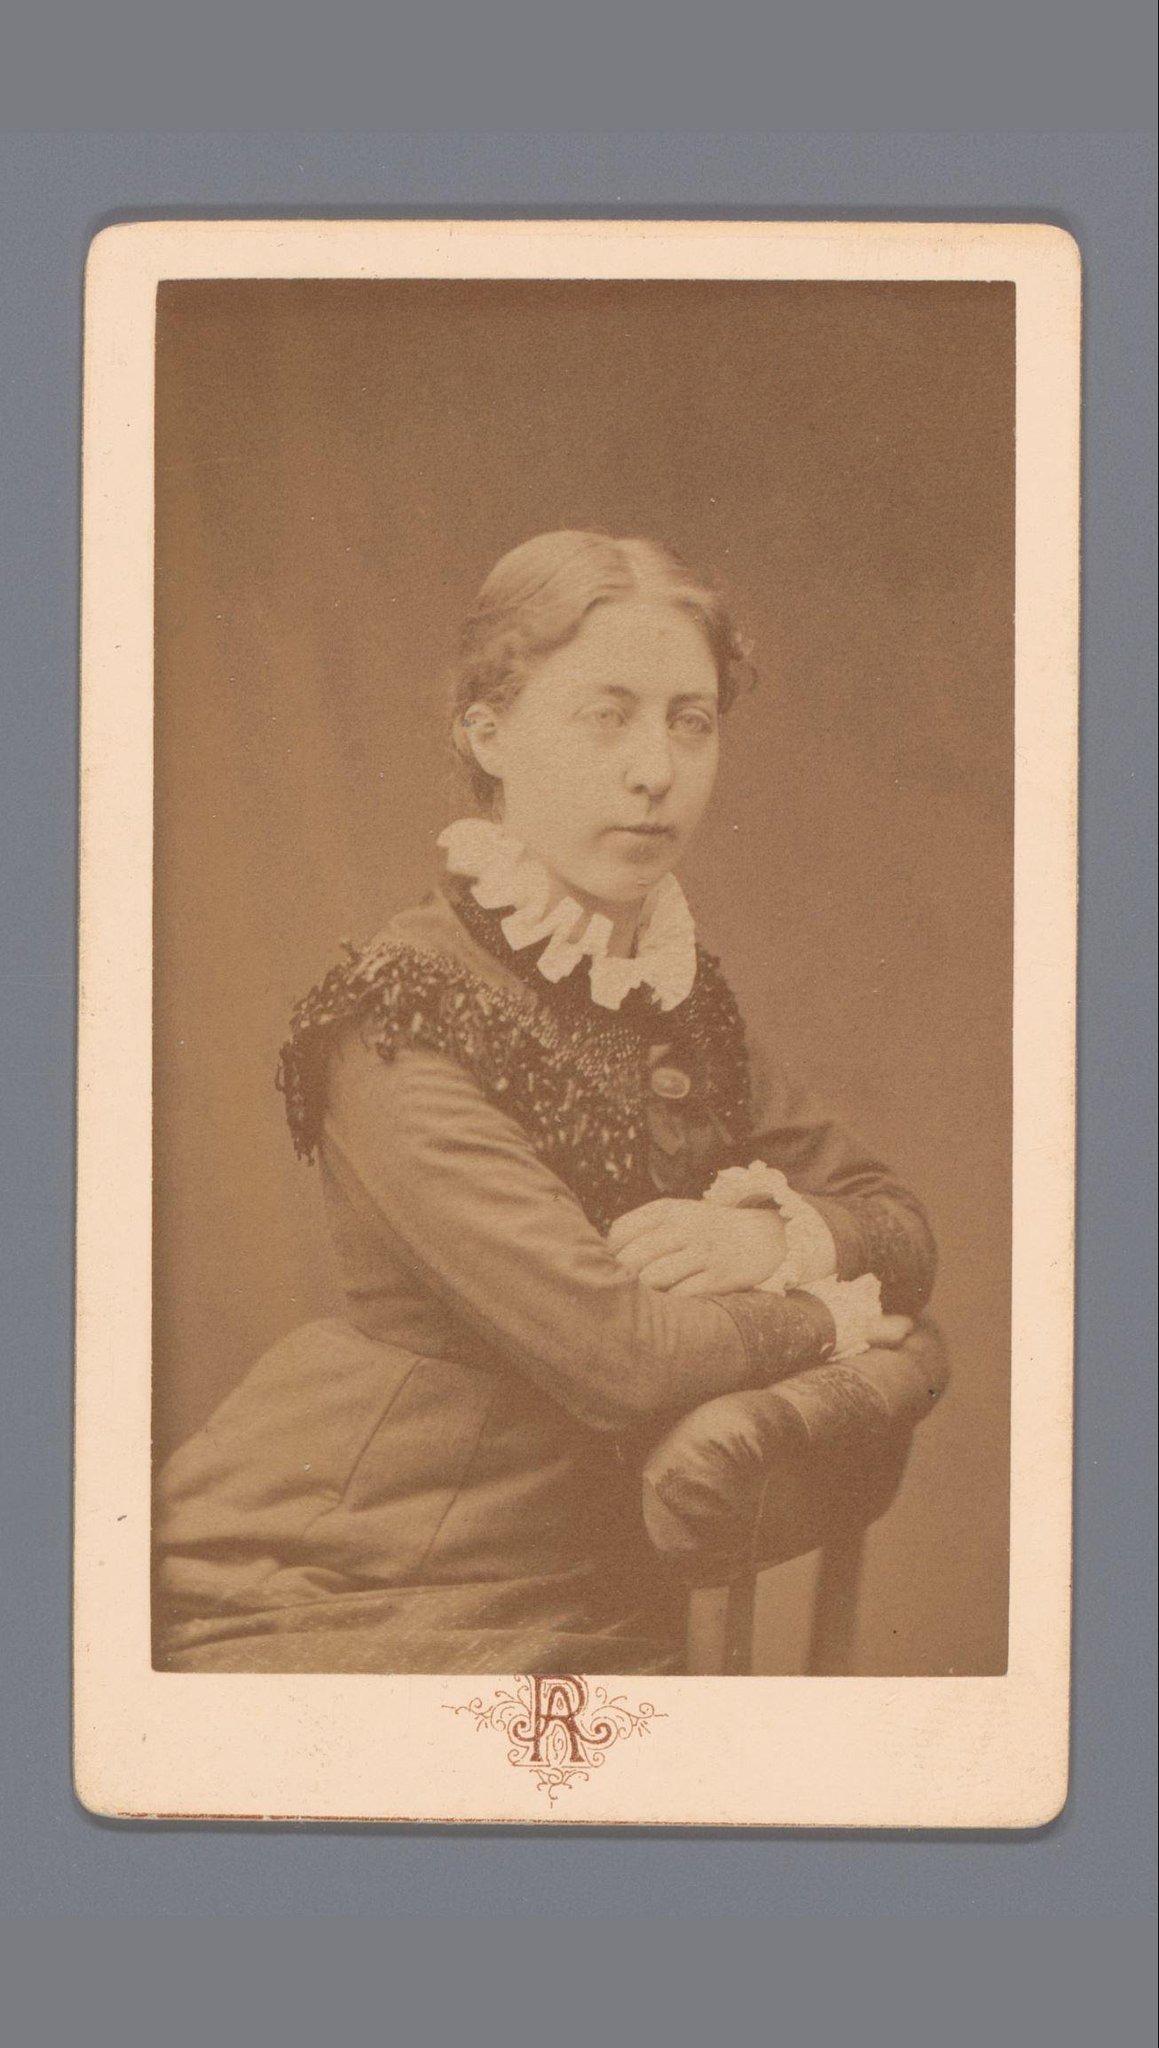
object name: photograph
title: Portret van een onbekende vrouw, achterstevoren zittend op een stoel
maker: alfred röhlander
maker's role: fotograaf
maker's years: 1838-1905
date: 1881-1905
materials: cardboard, paper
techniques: albumen print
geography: västervik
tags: sitting figure - aa - female human figure, historical persons - bb - woman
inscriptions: inscription: ‘WIMMERBY/ 1873./ ALF RÖHLANDER/ Atelier i/ WESTERVIK/ Plåten förvaras för efterbeställning.’, monogram: ‘AR’